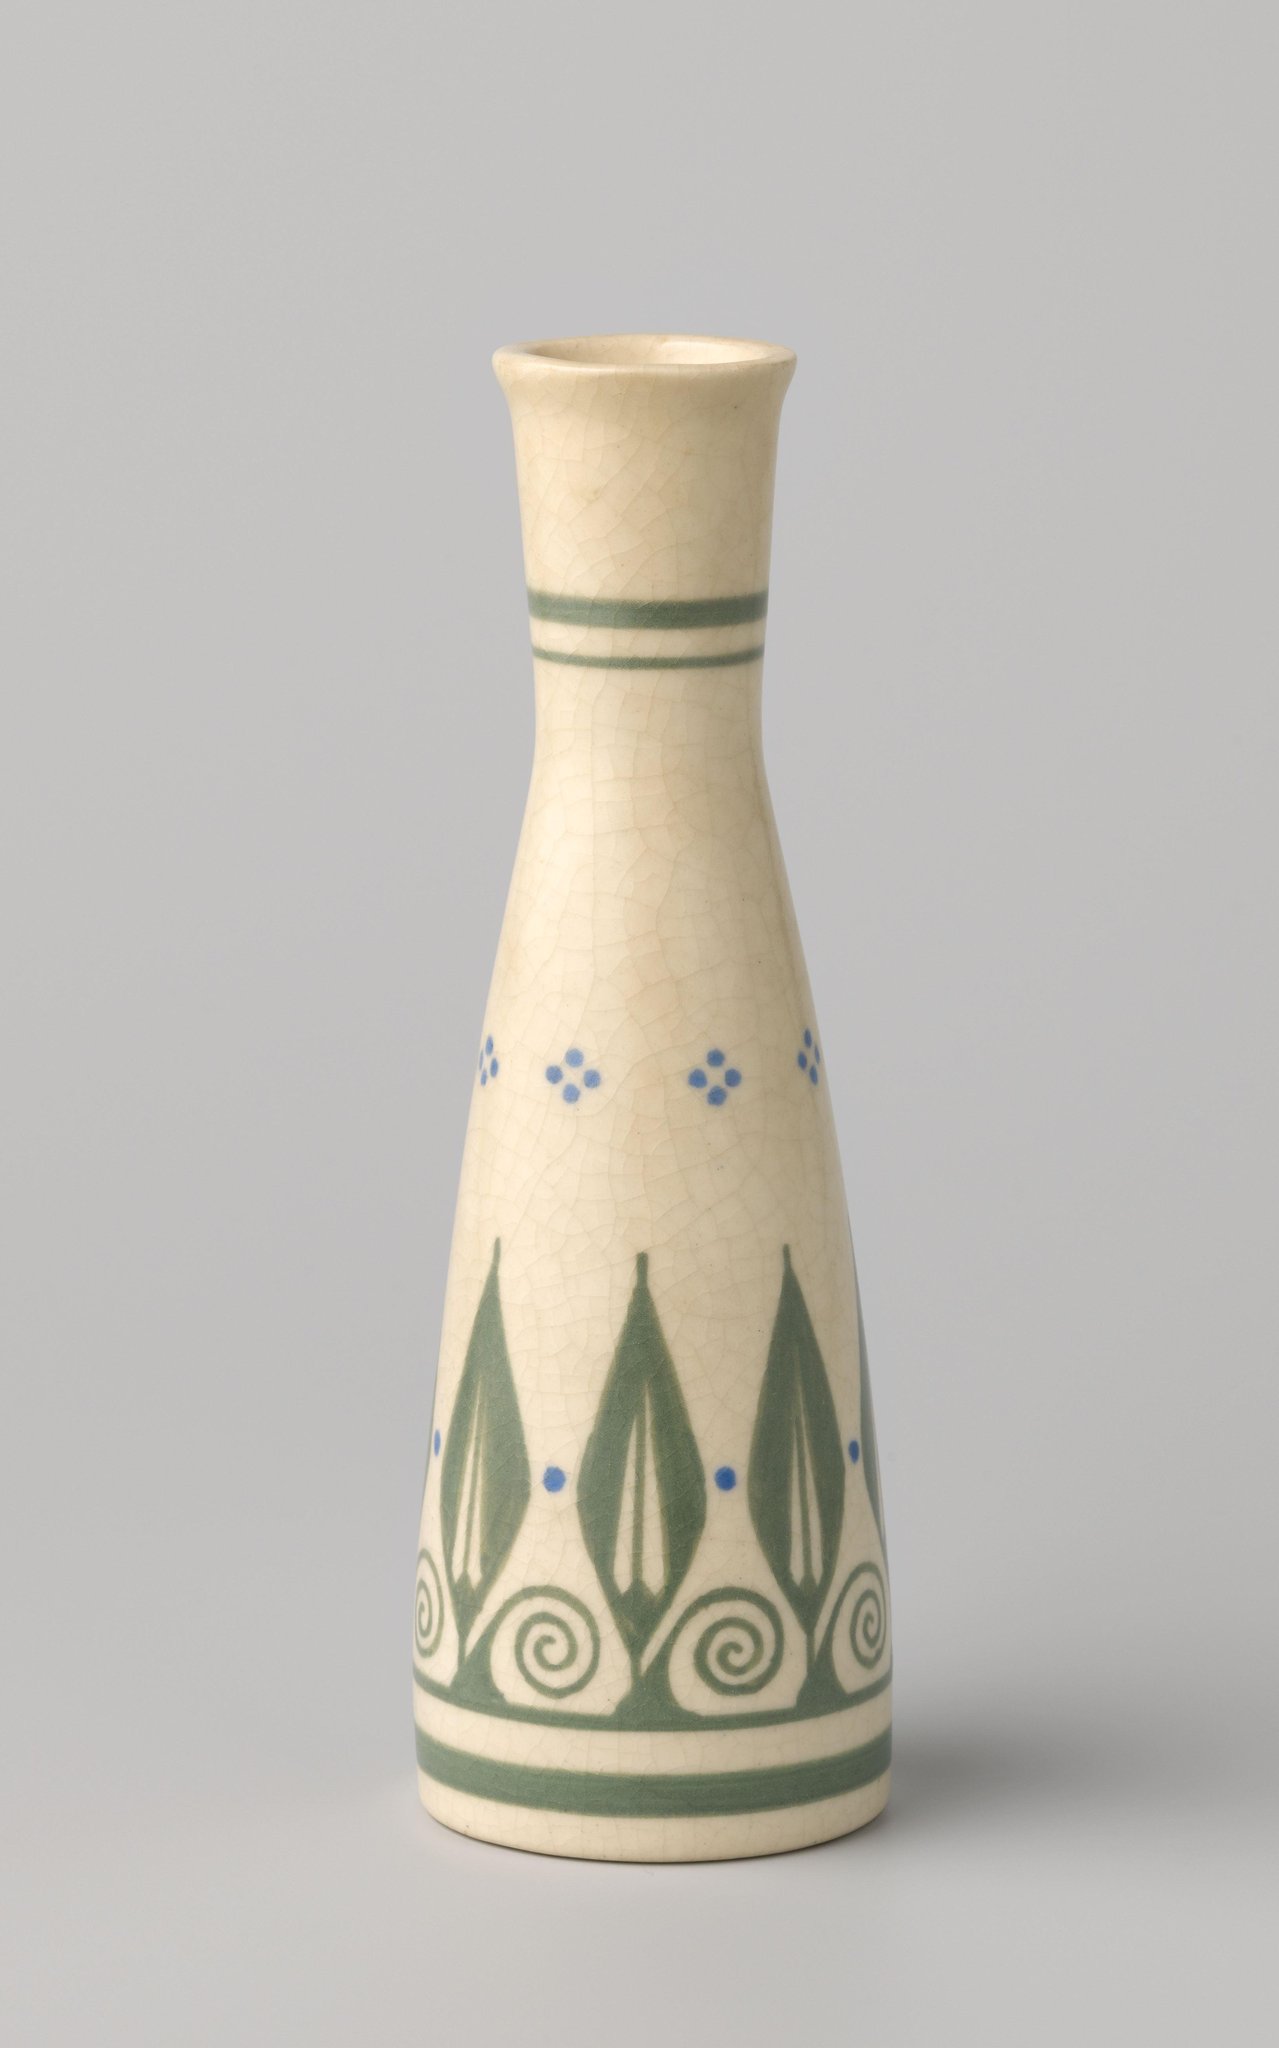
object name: vase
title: Vaas, versierd in groen en blauw op lichtgele matte grond met een gestileerd bladmotief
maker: bert nienhuis (i)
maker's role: designer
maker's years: 1873-1960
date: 1910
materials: earthenware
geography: amsterdam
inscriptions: mark: ‘fabrieksstempel (wapen van Amsterdam met 'Distel', en rondom 'Amsterdam Holland') in groen; een onduidelijk teken in blauw; ingegrift 237 en 3 (wellicht M of E?).’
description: Vaas van aardewerk, versierd in groen en blauw op lichtgele matte grond met een gestileerd bladmotief.